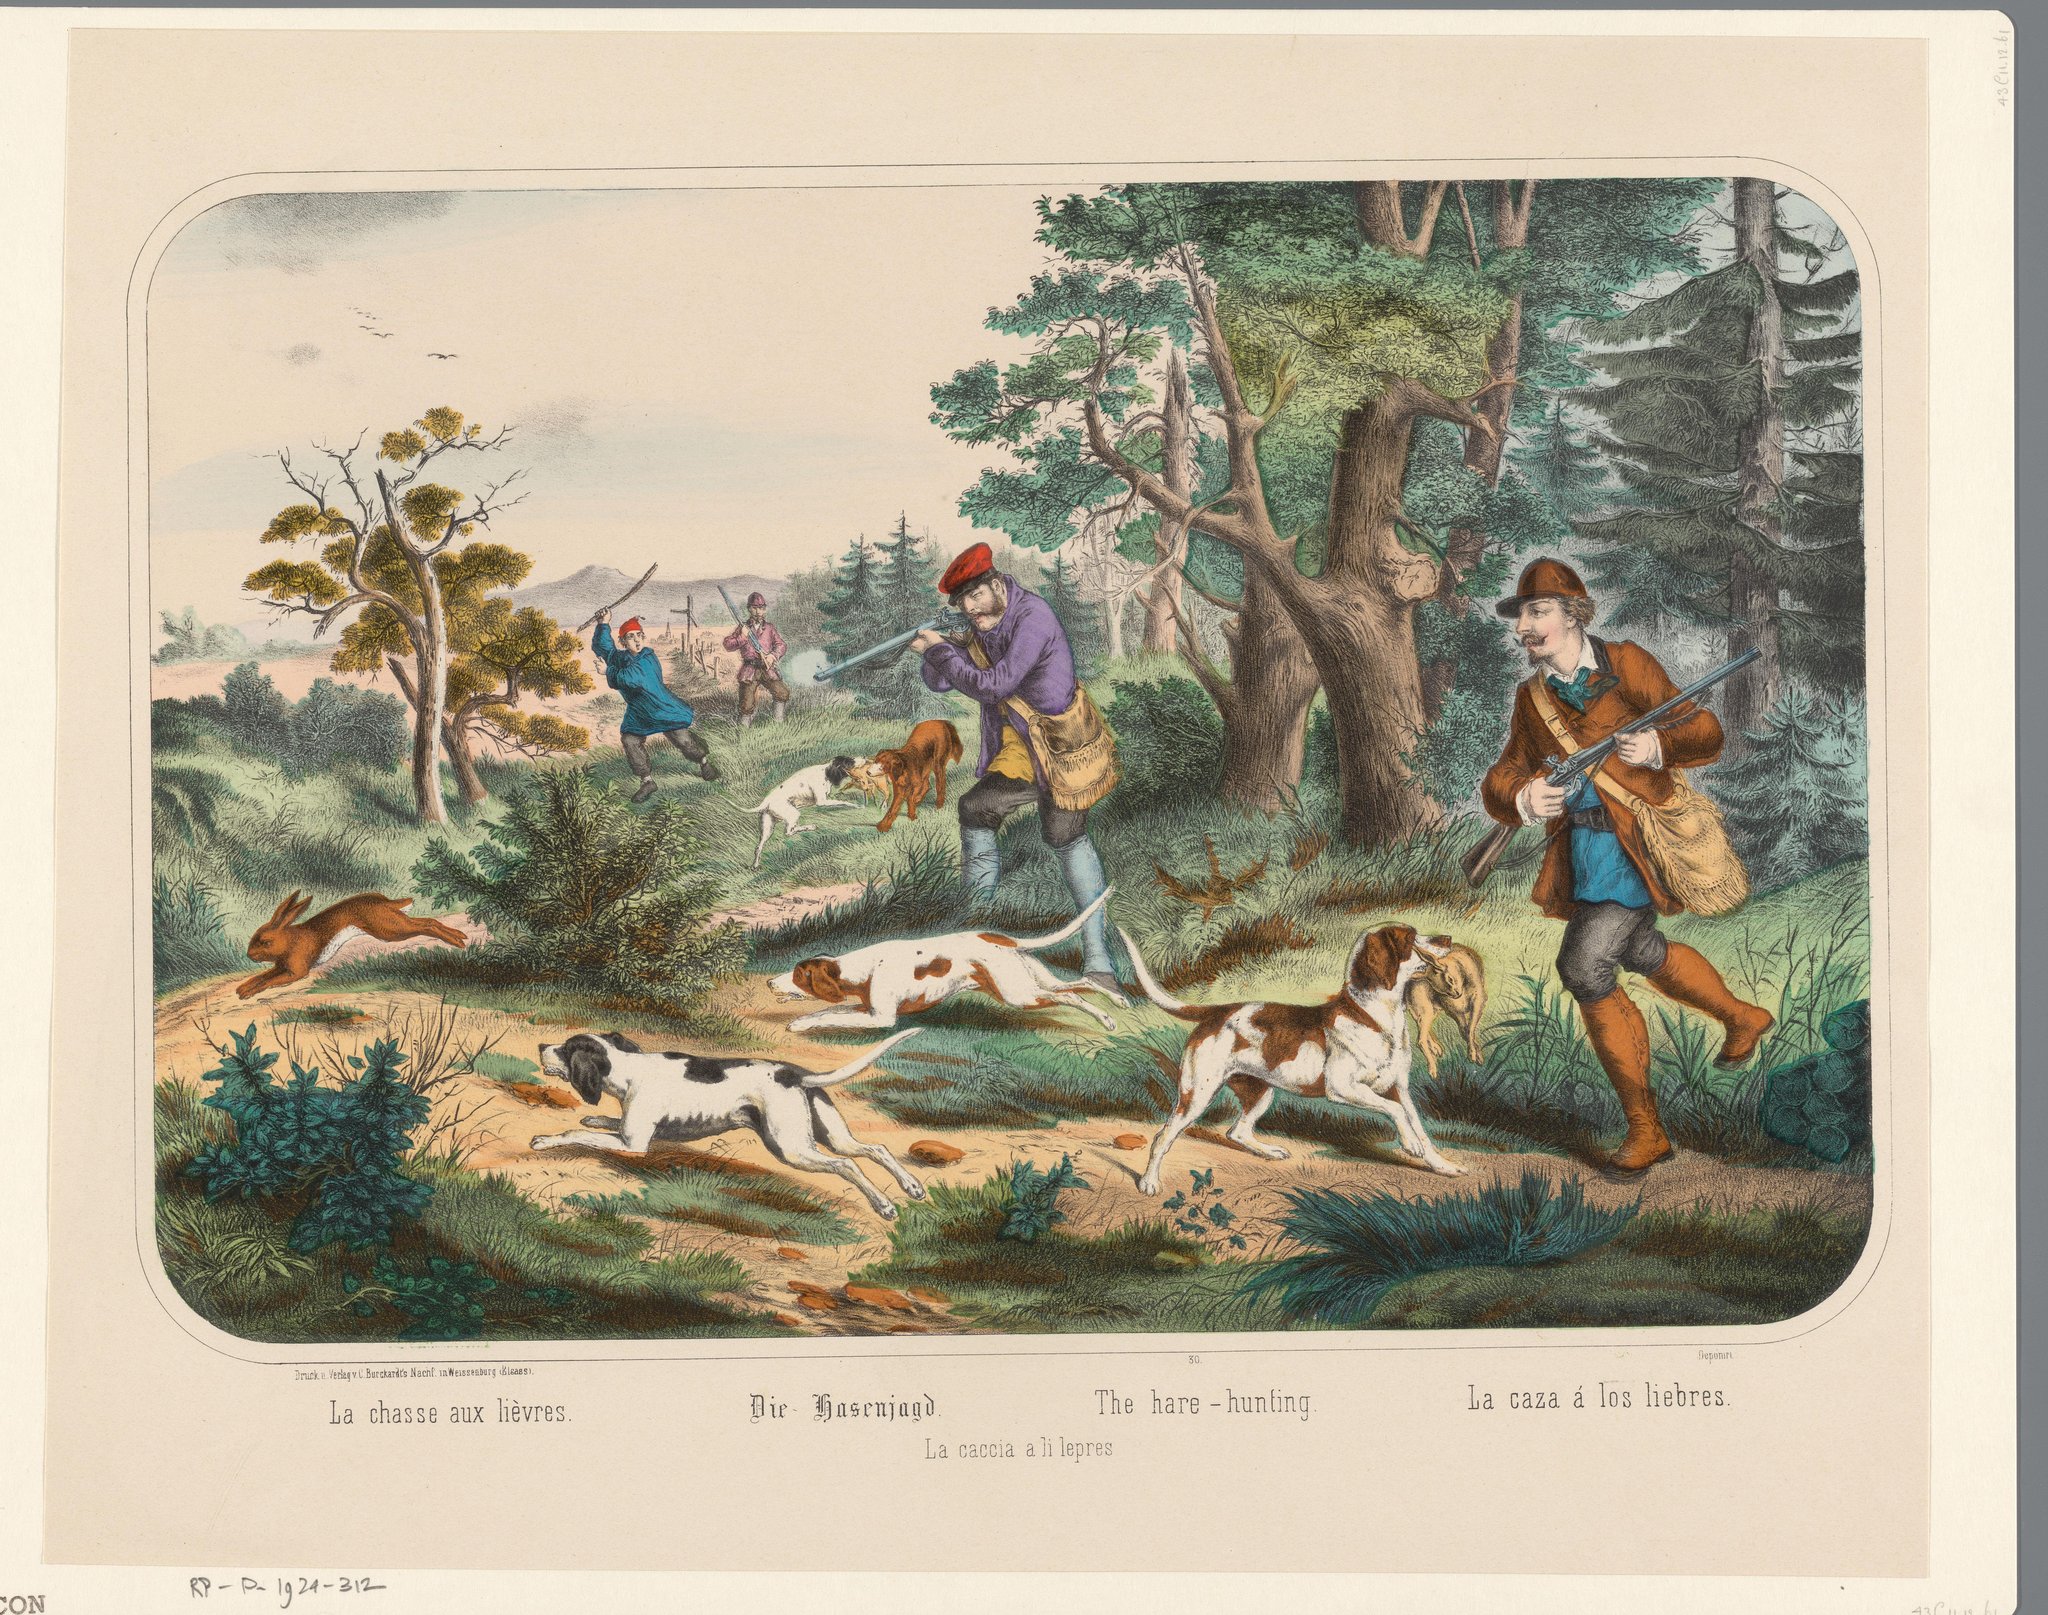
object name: print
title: La chasse aux lièvres ....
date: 1850-1900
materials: paper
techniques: hand coloring, lithograph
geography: weissenburg